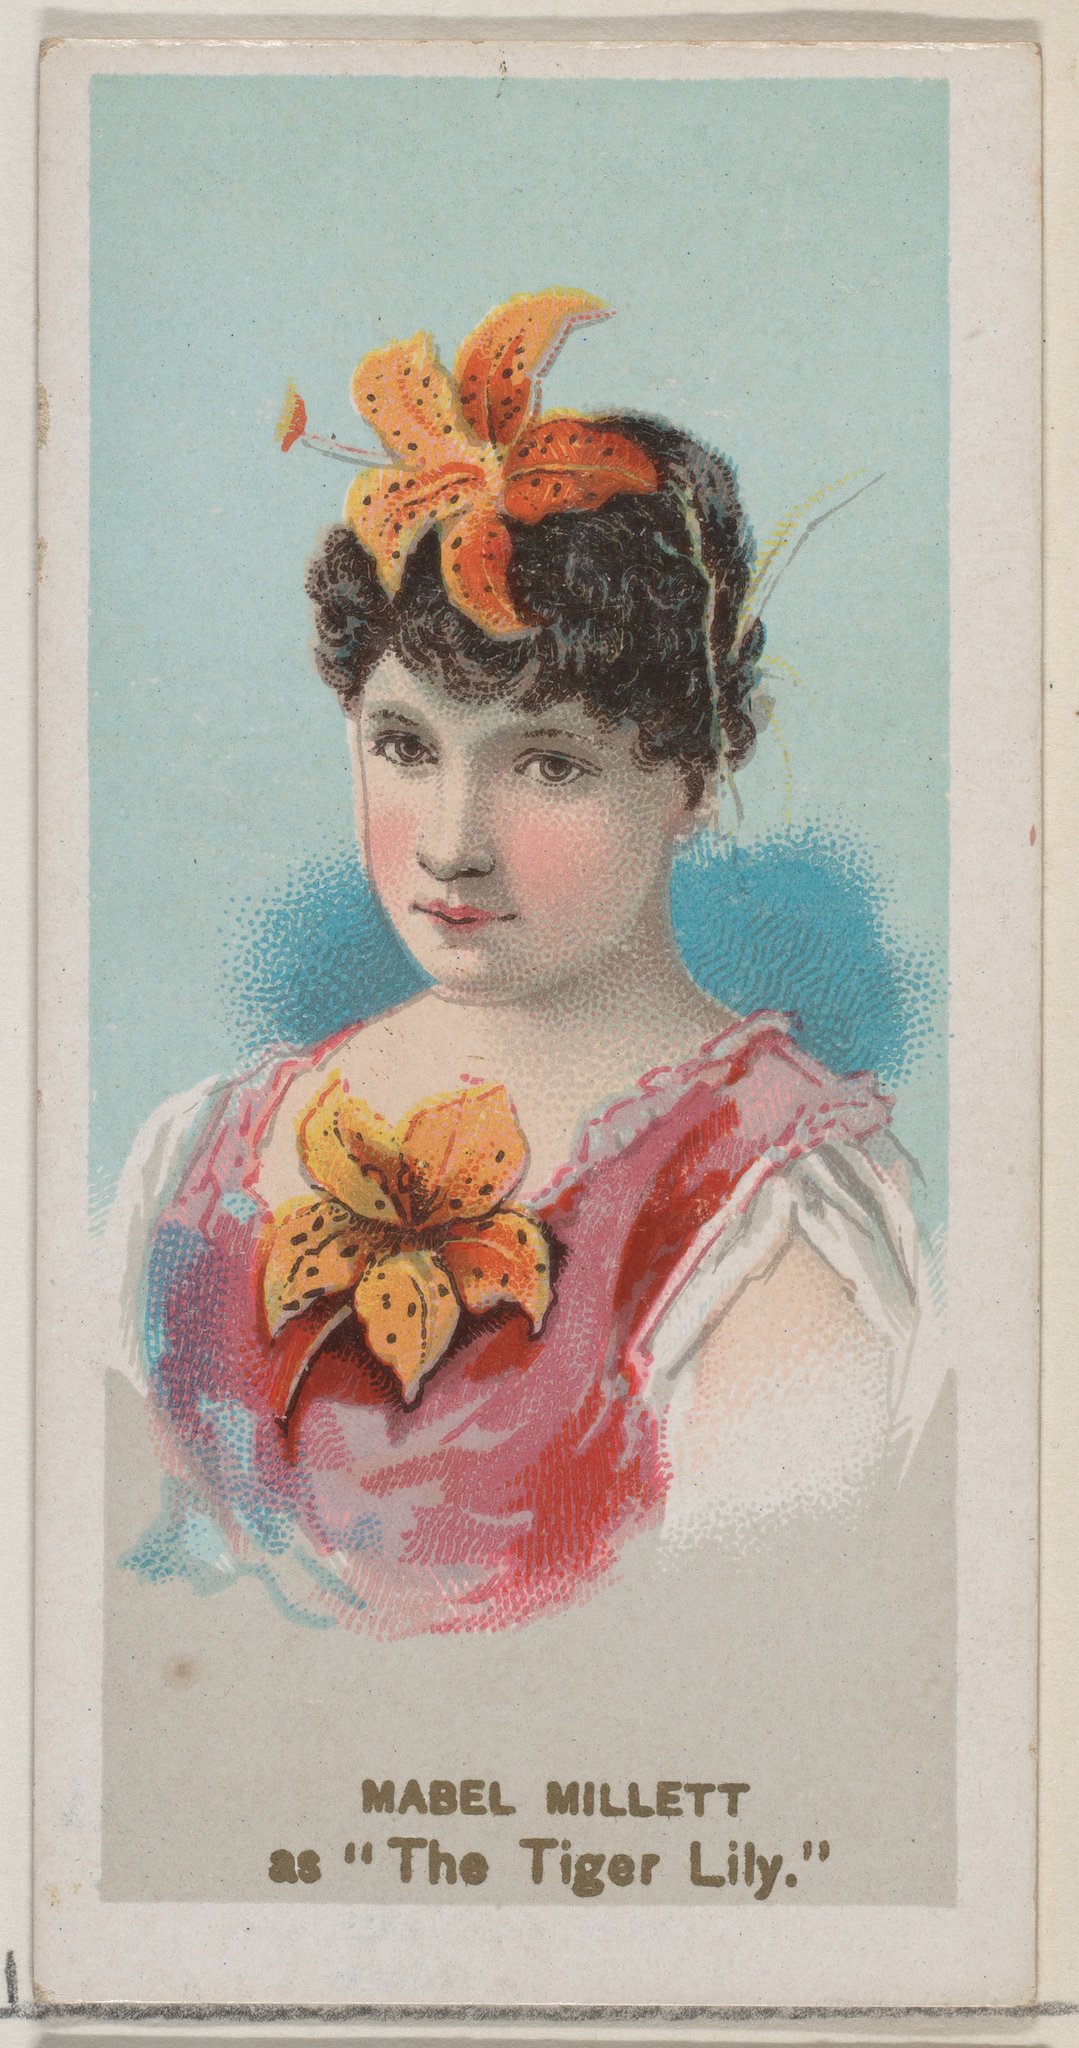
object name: print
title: Mabel Millett as "The Tiger Lily," from the series Fancy Dress Ball Costumes (N73) for Duke brand cigarettes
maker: w. duke, sons & co.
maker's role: publisher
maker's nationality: american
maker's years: 1870-1920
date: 1889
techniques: color lithograph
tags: women,lilies,actresses